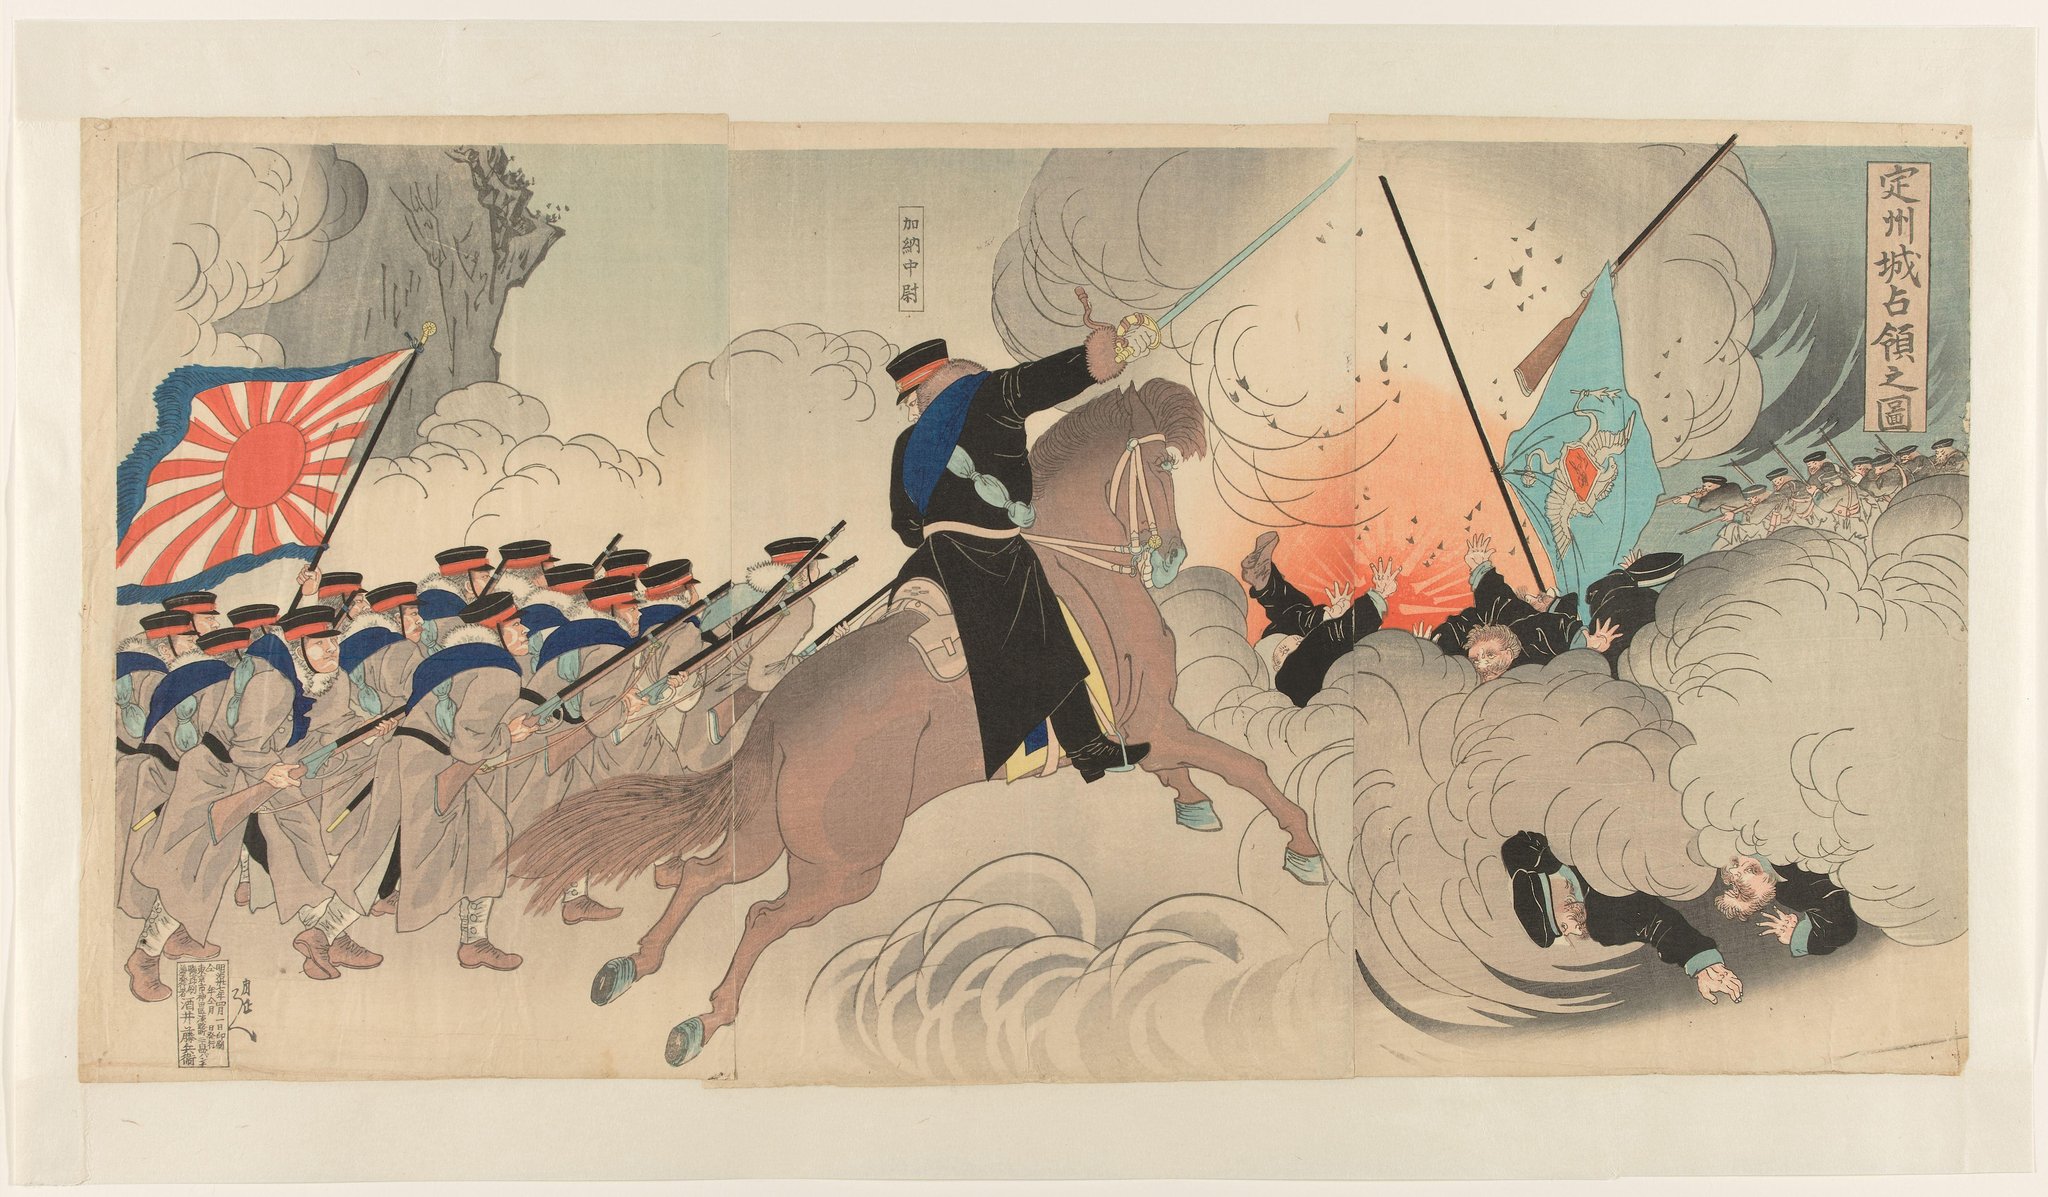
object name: print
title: Chonjujô senryô no zu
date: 1904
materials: paper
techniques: woodcut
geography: japan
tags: riding a horse, ass, or mule; rider, horseman, commander-in-chief, general, marshal, land forces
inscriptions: collector's mark: Lugt 2228, label: ‘2541 no. 4’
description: Eerste luitenant Kano te paard leidt Japanse soldaten in de strijd met de Russen. Luitenant Kano komt om bij deze eerste slag op het land van de Russisch-Japanse Oorlog.